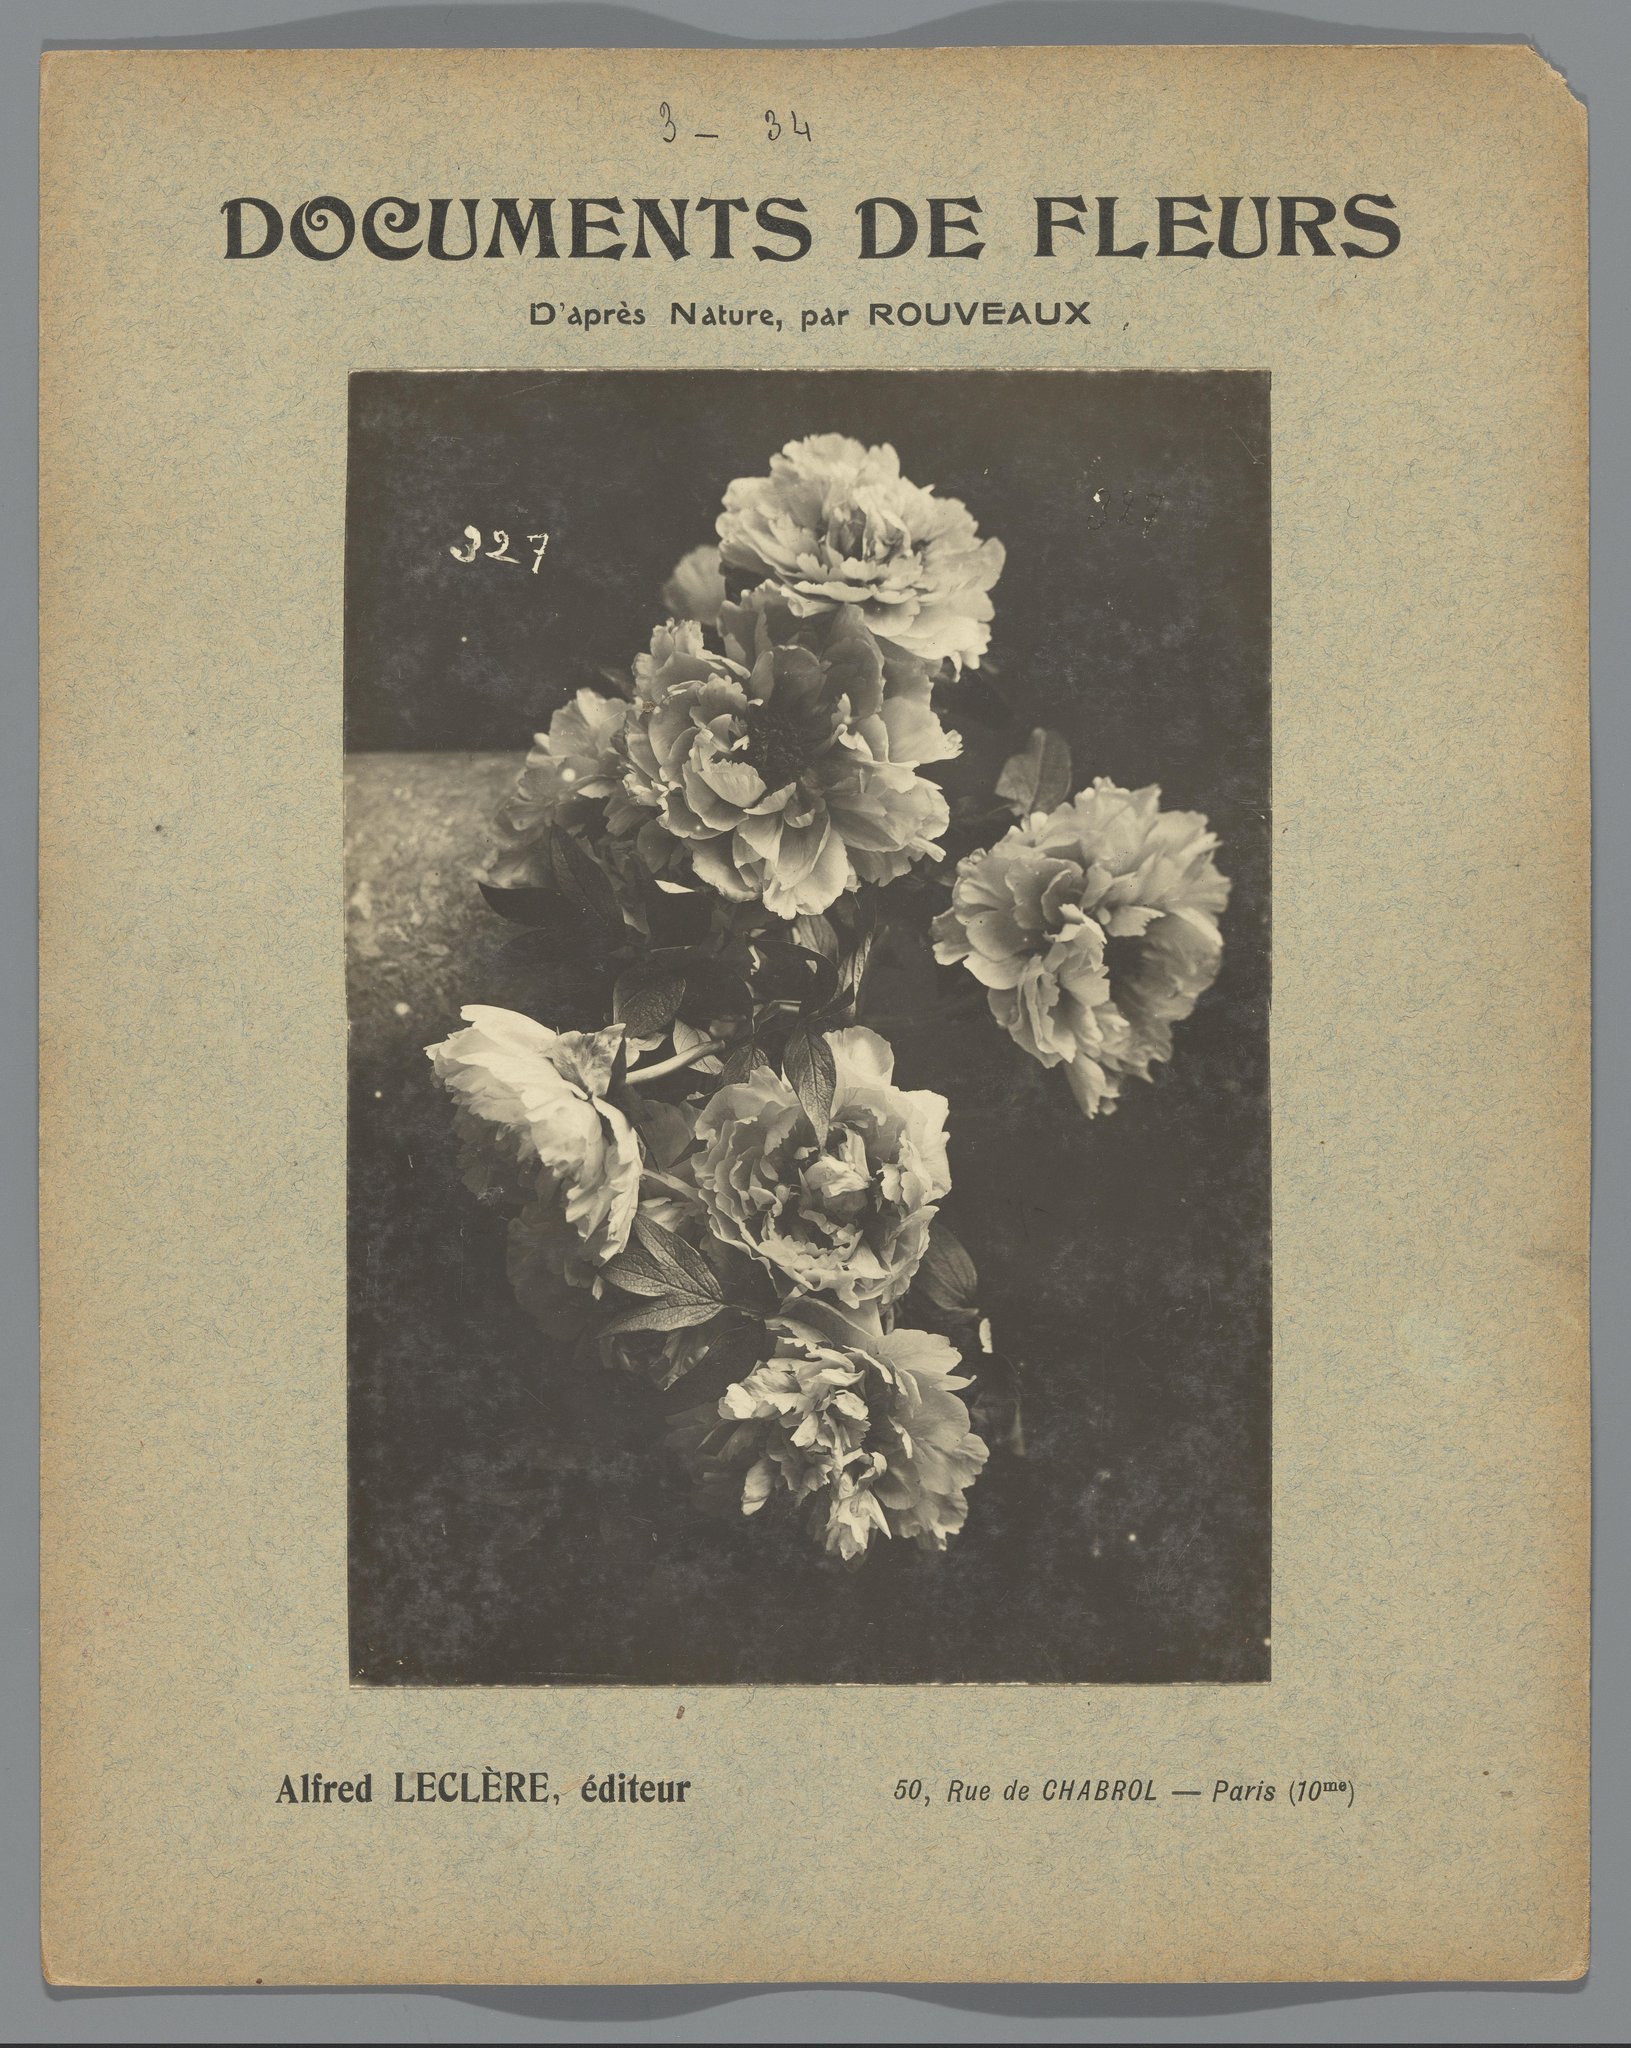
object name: photograph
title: Bloemstudie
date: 1895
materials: photographic support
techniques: gelatin silver print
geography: france